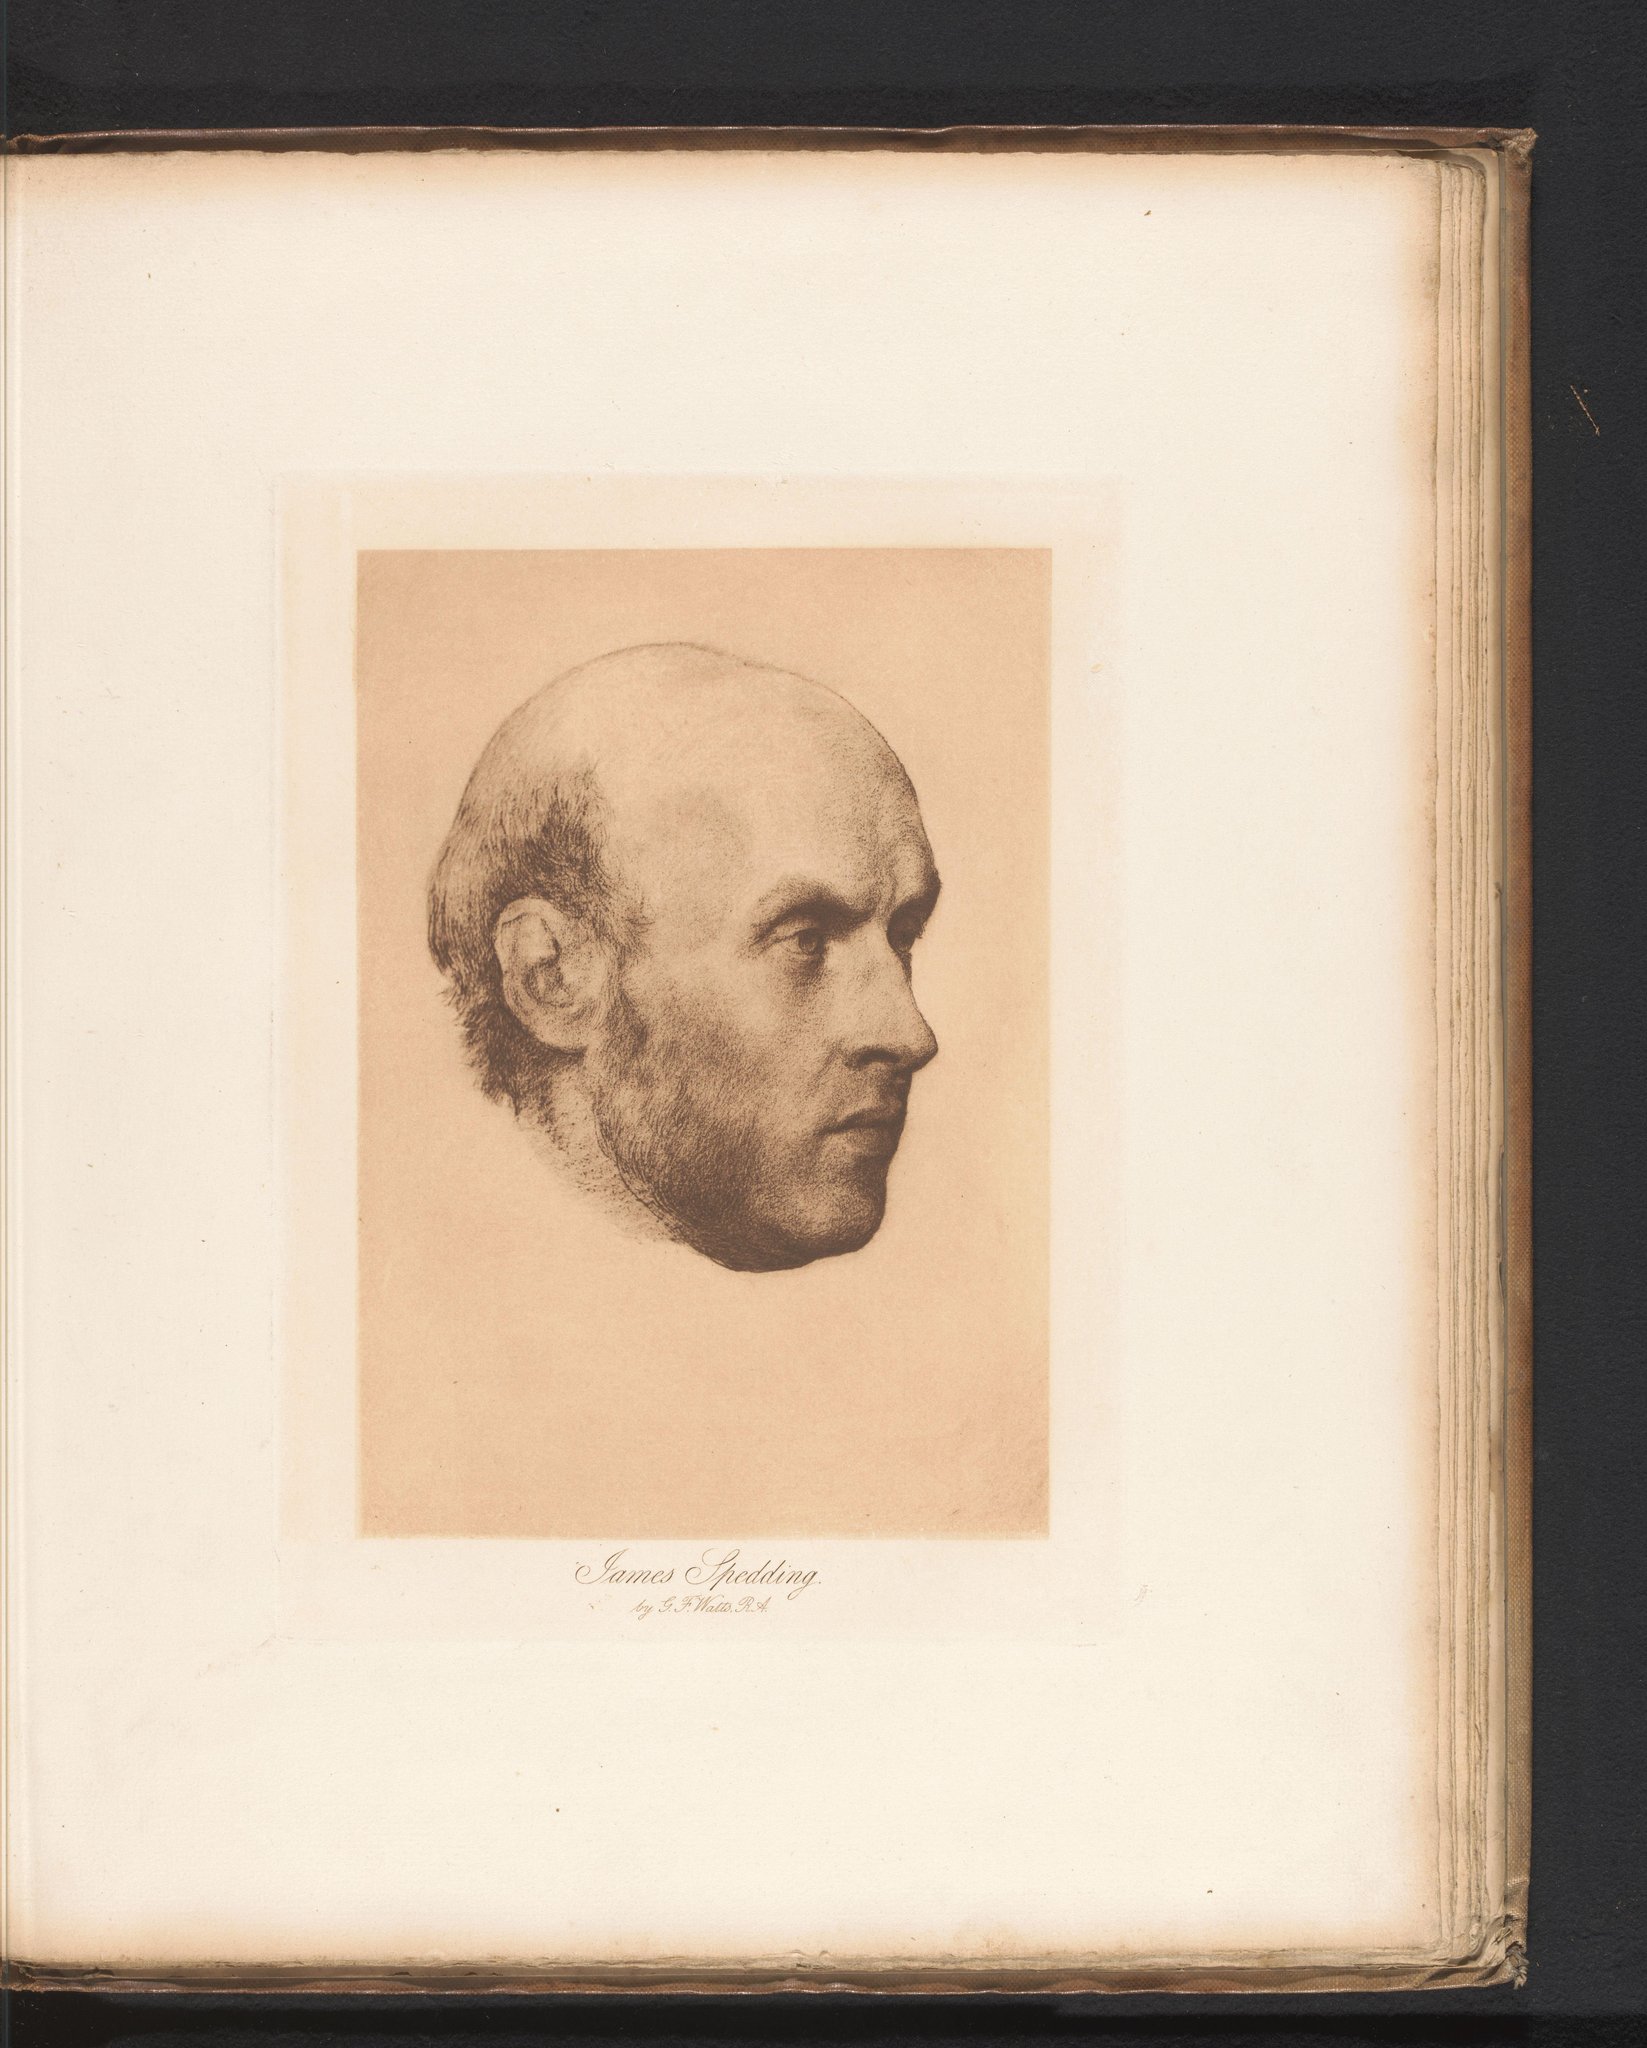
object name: reproduction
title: Reproductie van een tekening van een portret van James Spedding door George Frederick Watts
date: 1888-1893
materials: paper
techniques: photoaquatint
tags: draughtsman, james spedding, historical persons, portrait of a writer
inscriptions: inscription: ‘James Spedding./ by G. F. Watts. R. A.’